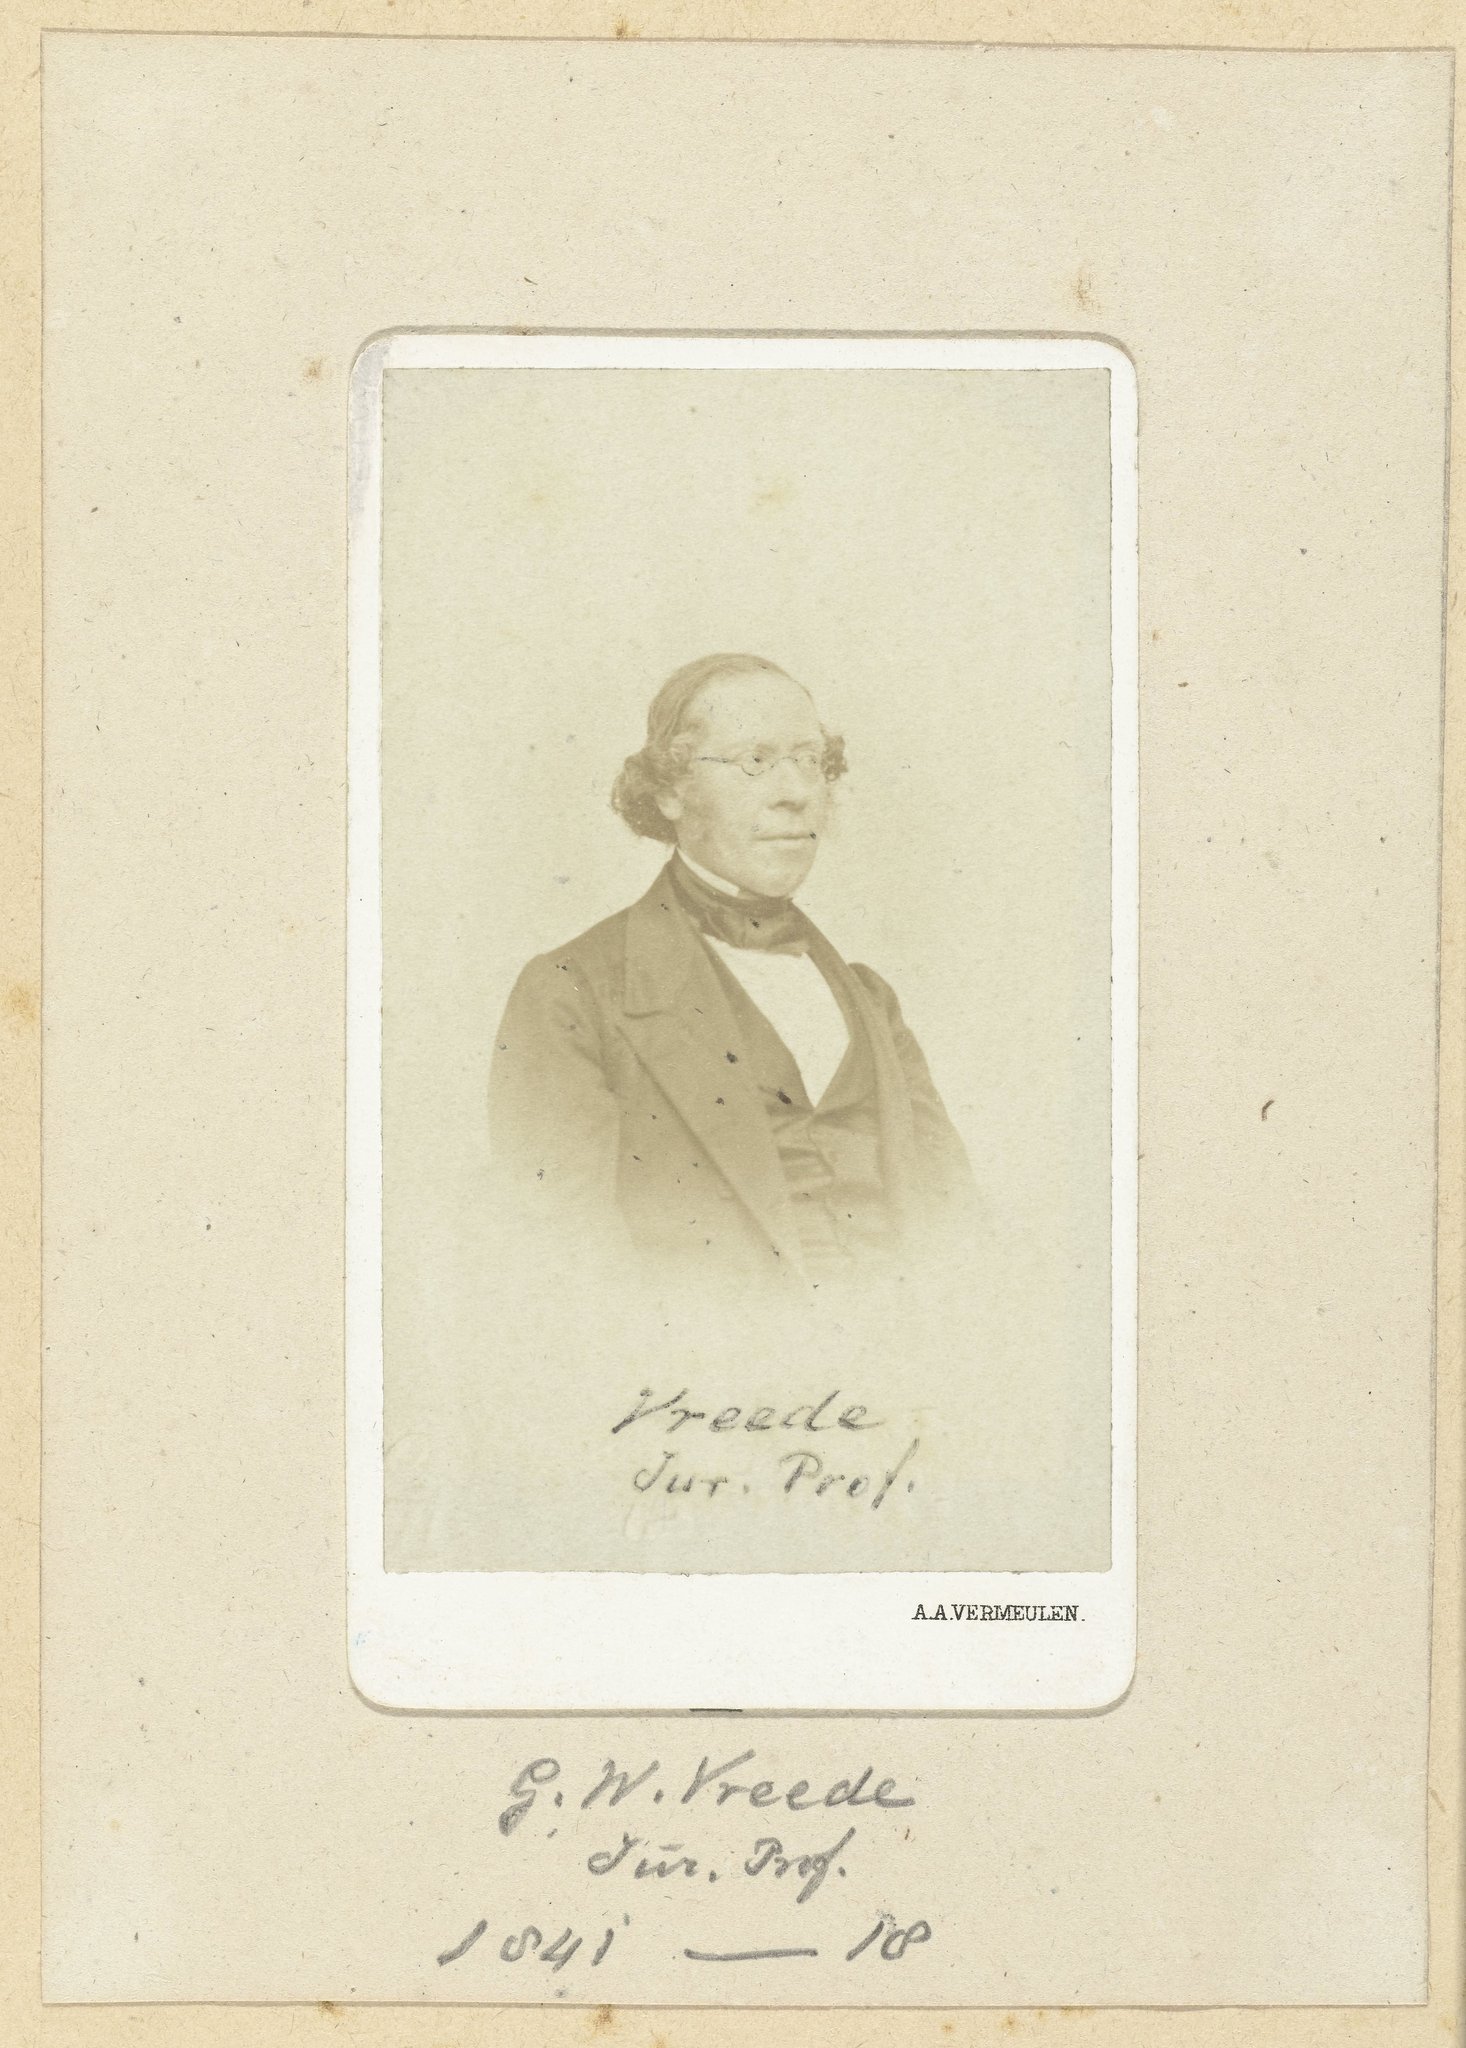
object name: carte de visite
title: G.W. Vreede, jur. prof. 1841 - 18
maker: abraham adrianus vermeulen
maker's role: painter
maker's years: 1817-1894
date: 1860-1880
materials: paper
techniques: albumen print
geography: utrecht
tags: utrecht, george willem vreede, historical persons (portraits and scenes from the life)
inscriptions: name: ‘G.W. Vreede, jur. prof. 1841 - 18’